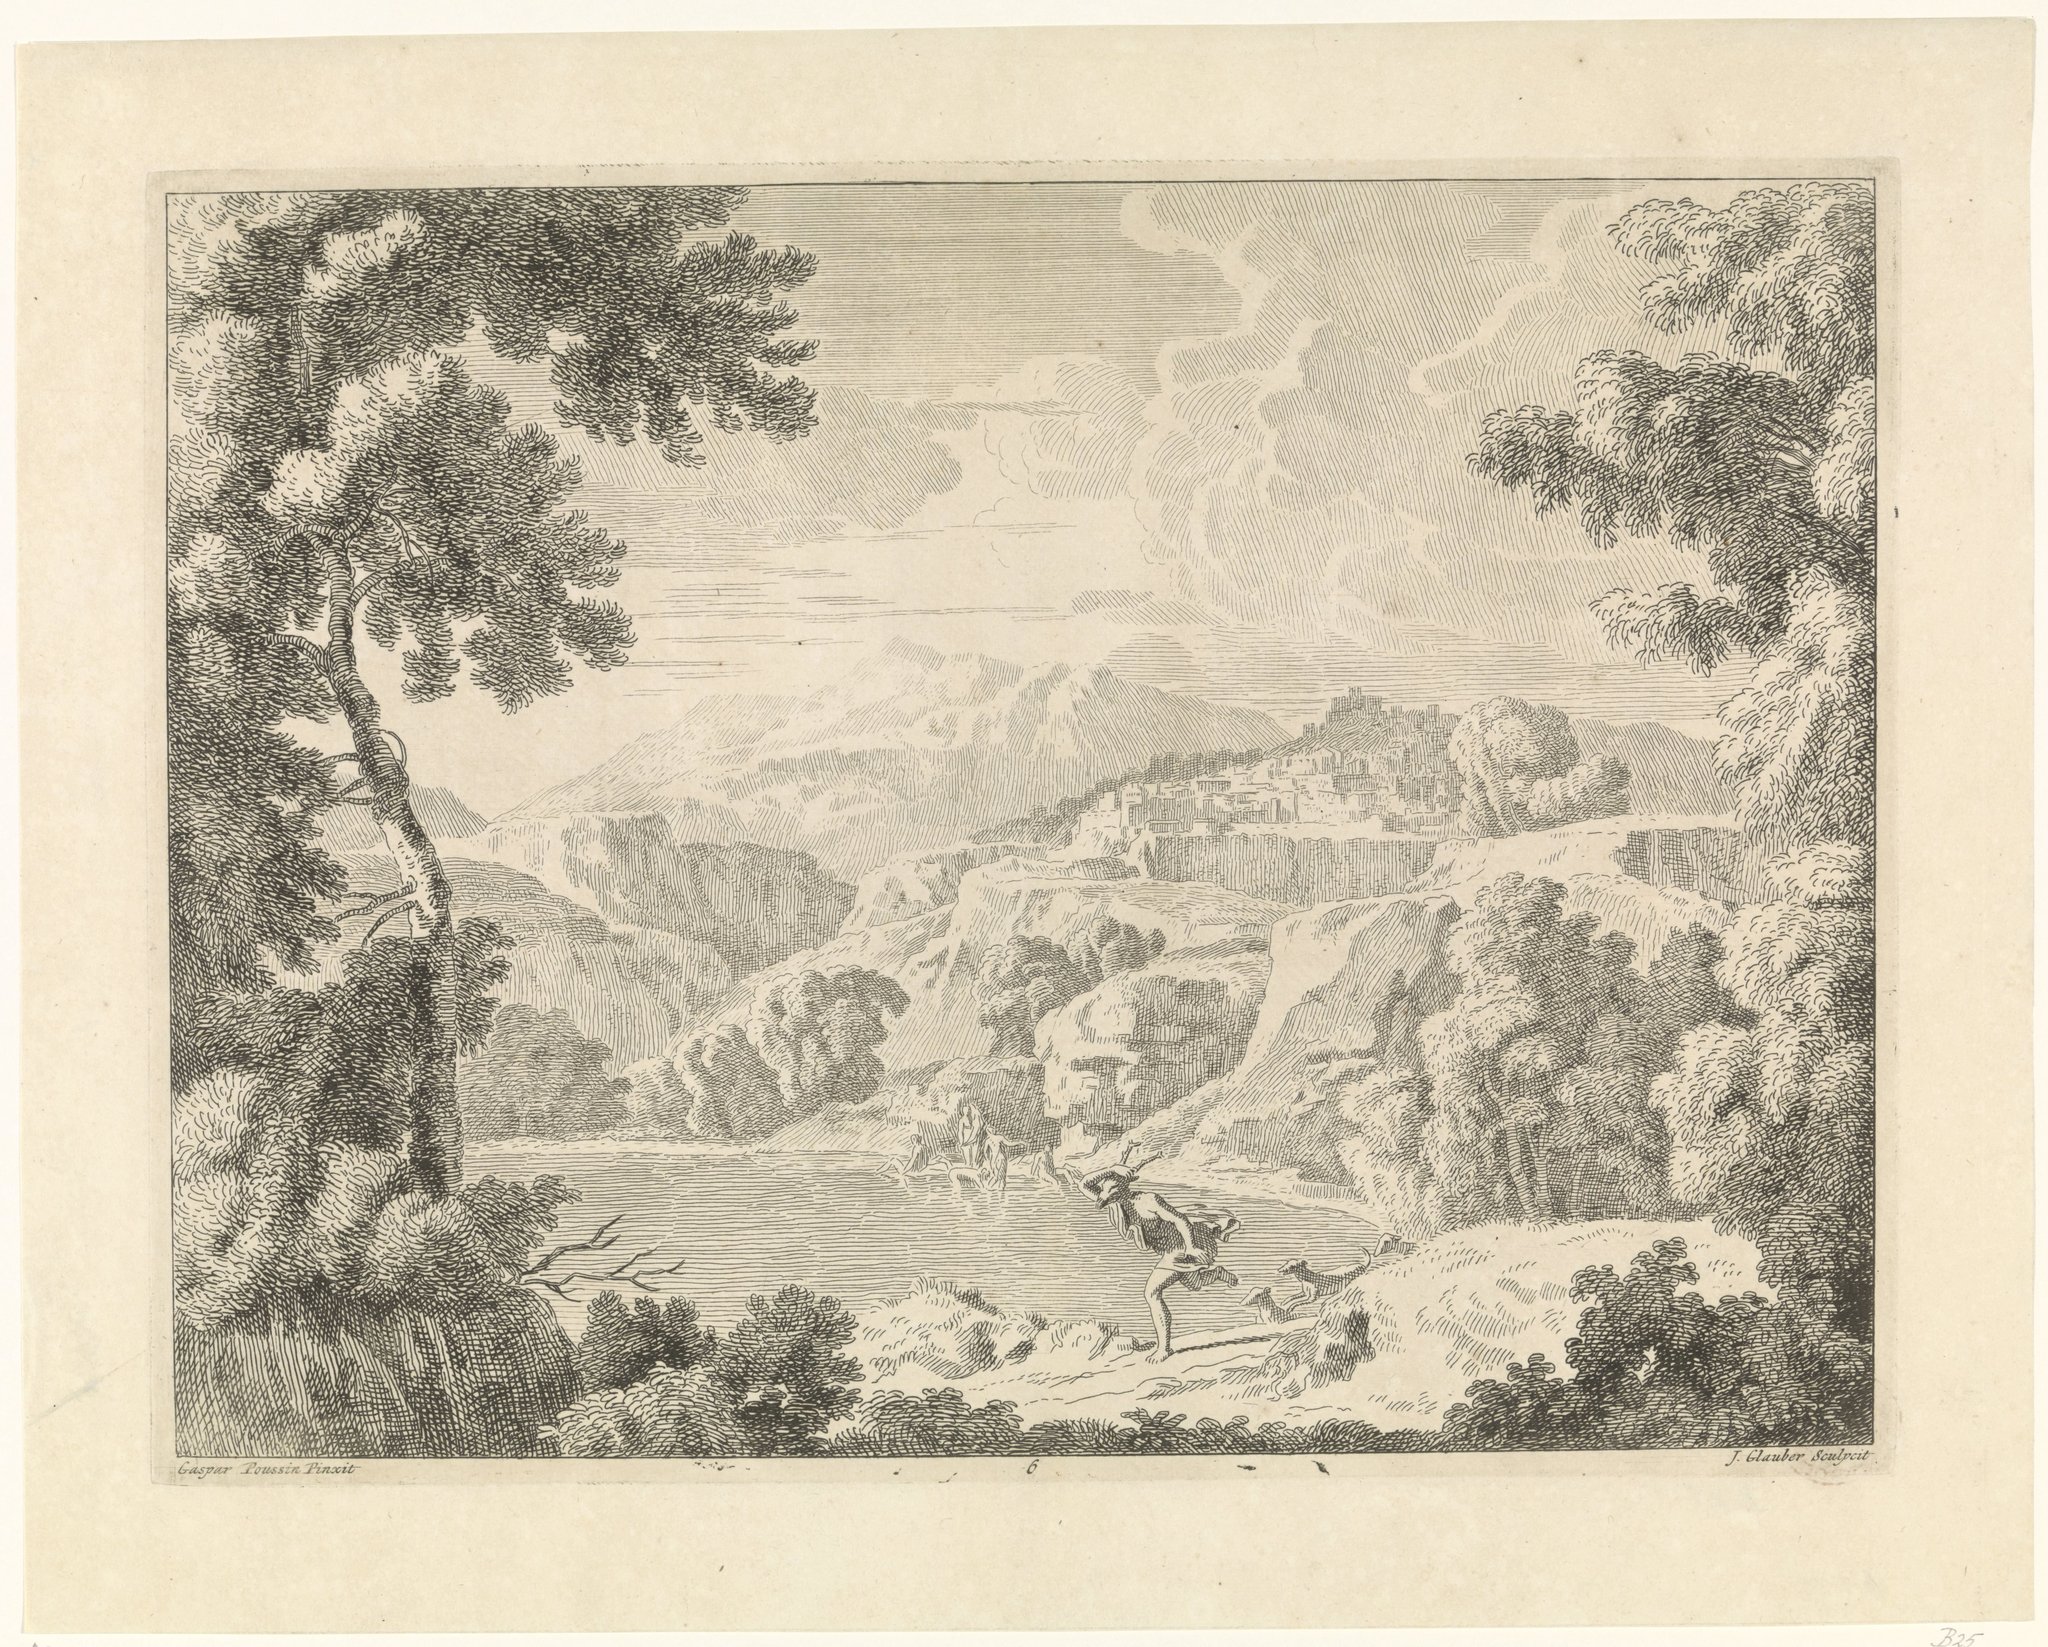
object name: print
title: Landschappen naar Gaspar Poussin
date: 1656-1726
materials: paper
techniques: etching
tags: actaeon changed into a stag: as punishment for seeing her bathe, diana changes actaeon, the hunter, into a stag (ovid, metamorphoses iii 193), diana bathing with her nymphs, (high) hill - hh - ideal landscapes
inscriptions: collector's mark: Lugt 240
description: Een heuvelachtig landschap. Op de voorgrond Actaeon die, achterna gezeten door zijn eigen honden, in een hert verandert. Op de achtergrond de badende Diana en haar nimfen. De prent maakt deel uit van een serie van landschappen naar schilderijen van Gaspar Poussin.